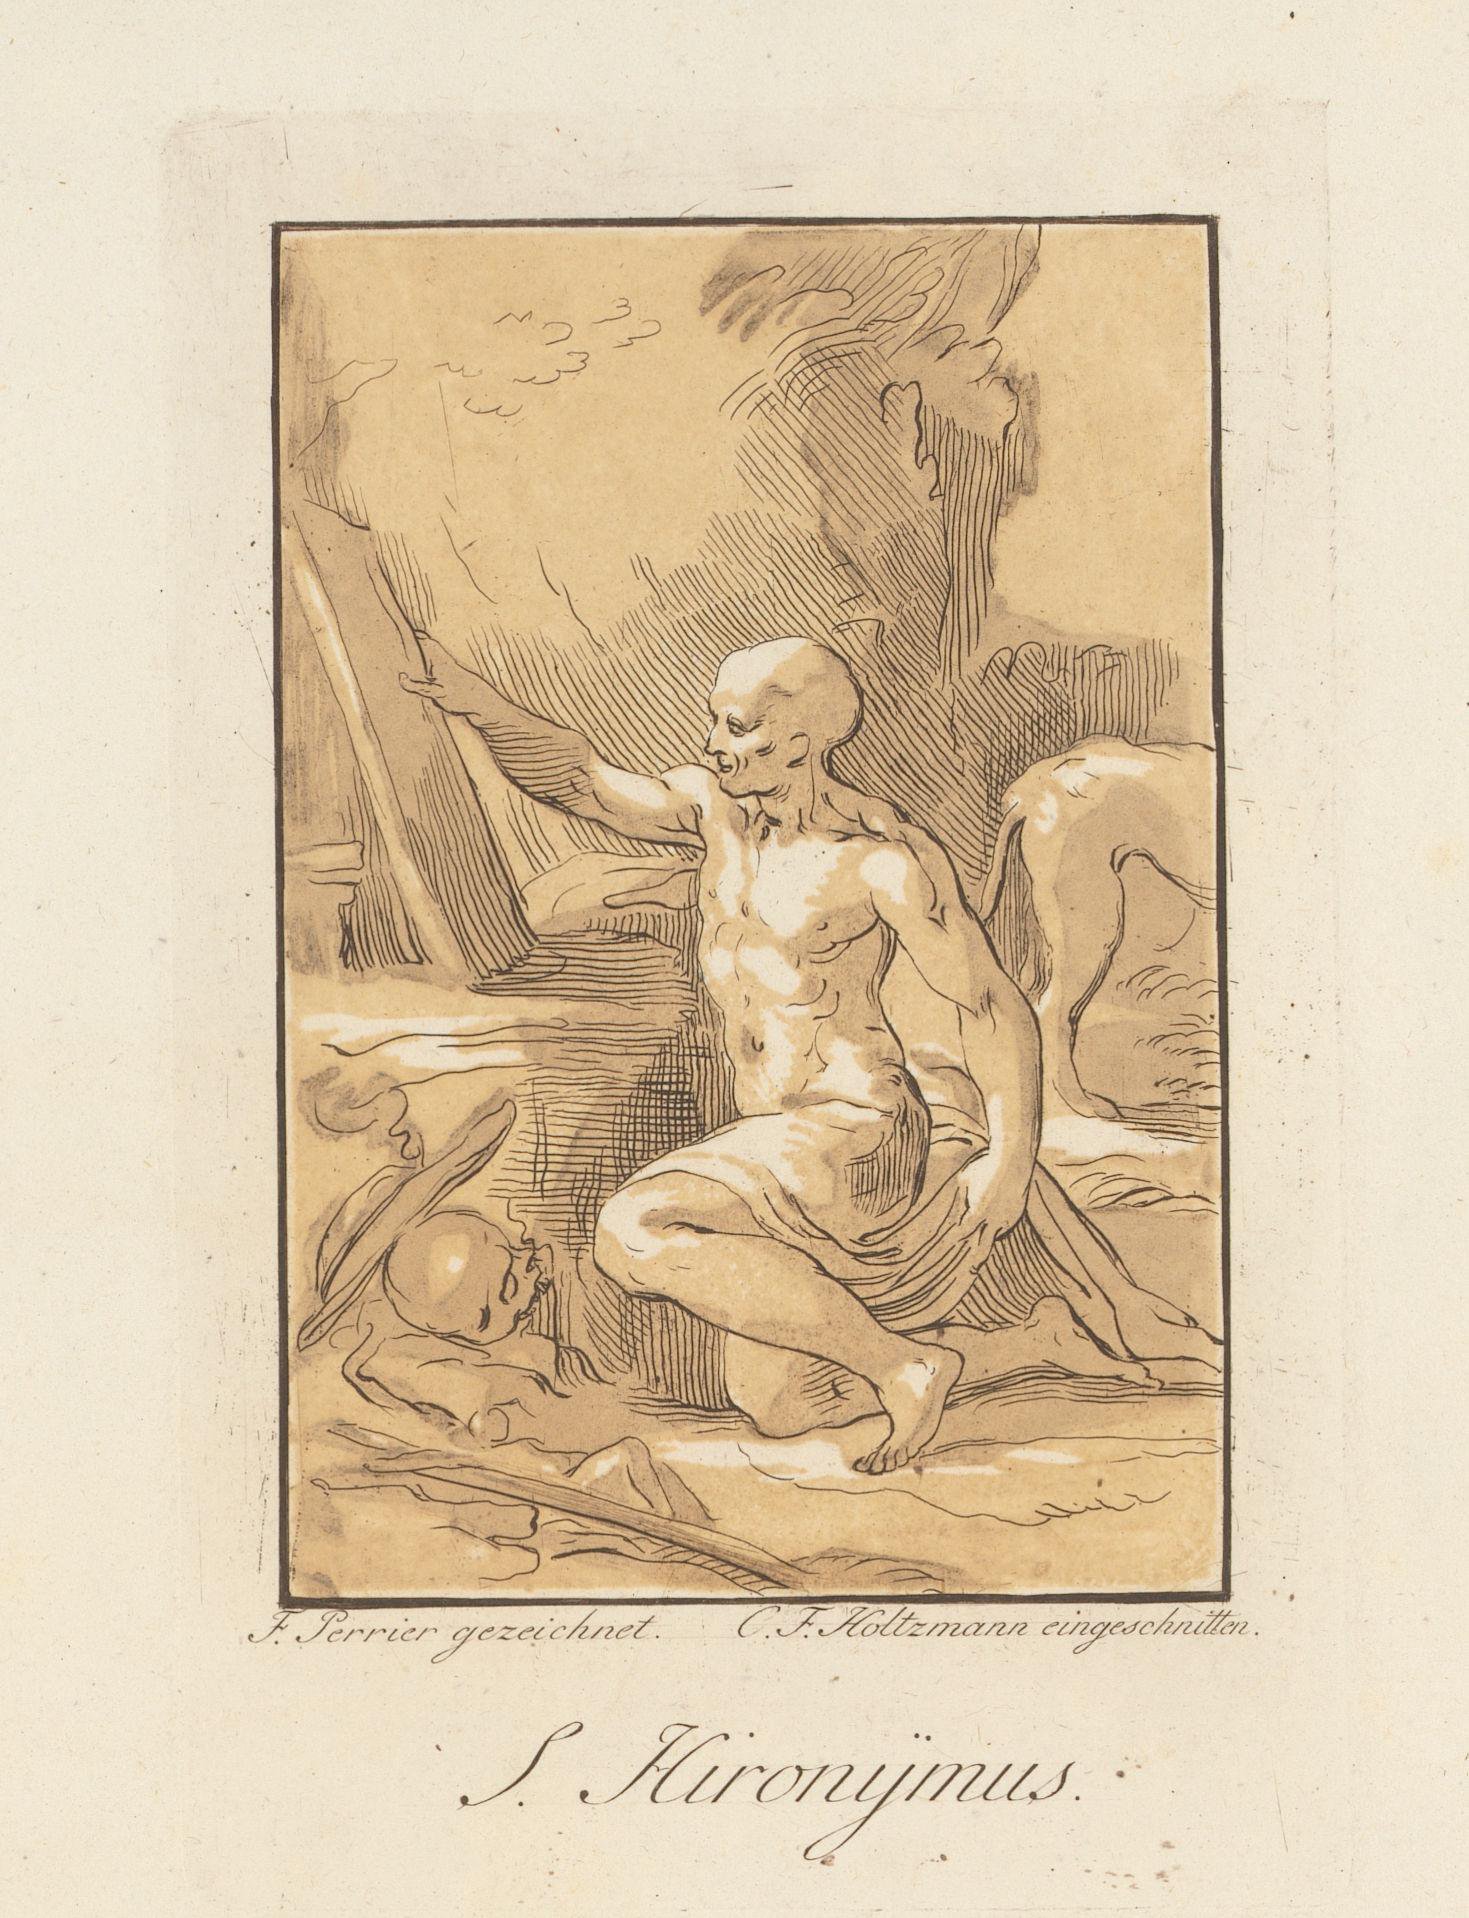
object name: album leaf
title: S. Hironijmus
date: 1750-1811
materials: paper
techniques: etching, intaglio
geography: dresden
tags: the monk and hermit jerome (hieronymus); possible attributes: book, cardinal's hat, crucifix, hour-glass, lion, skull, stone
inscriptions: collector's mark: Lugt 2760, collector's mark: Lugt 2228